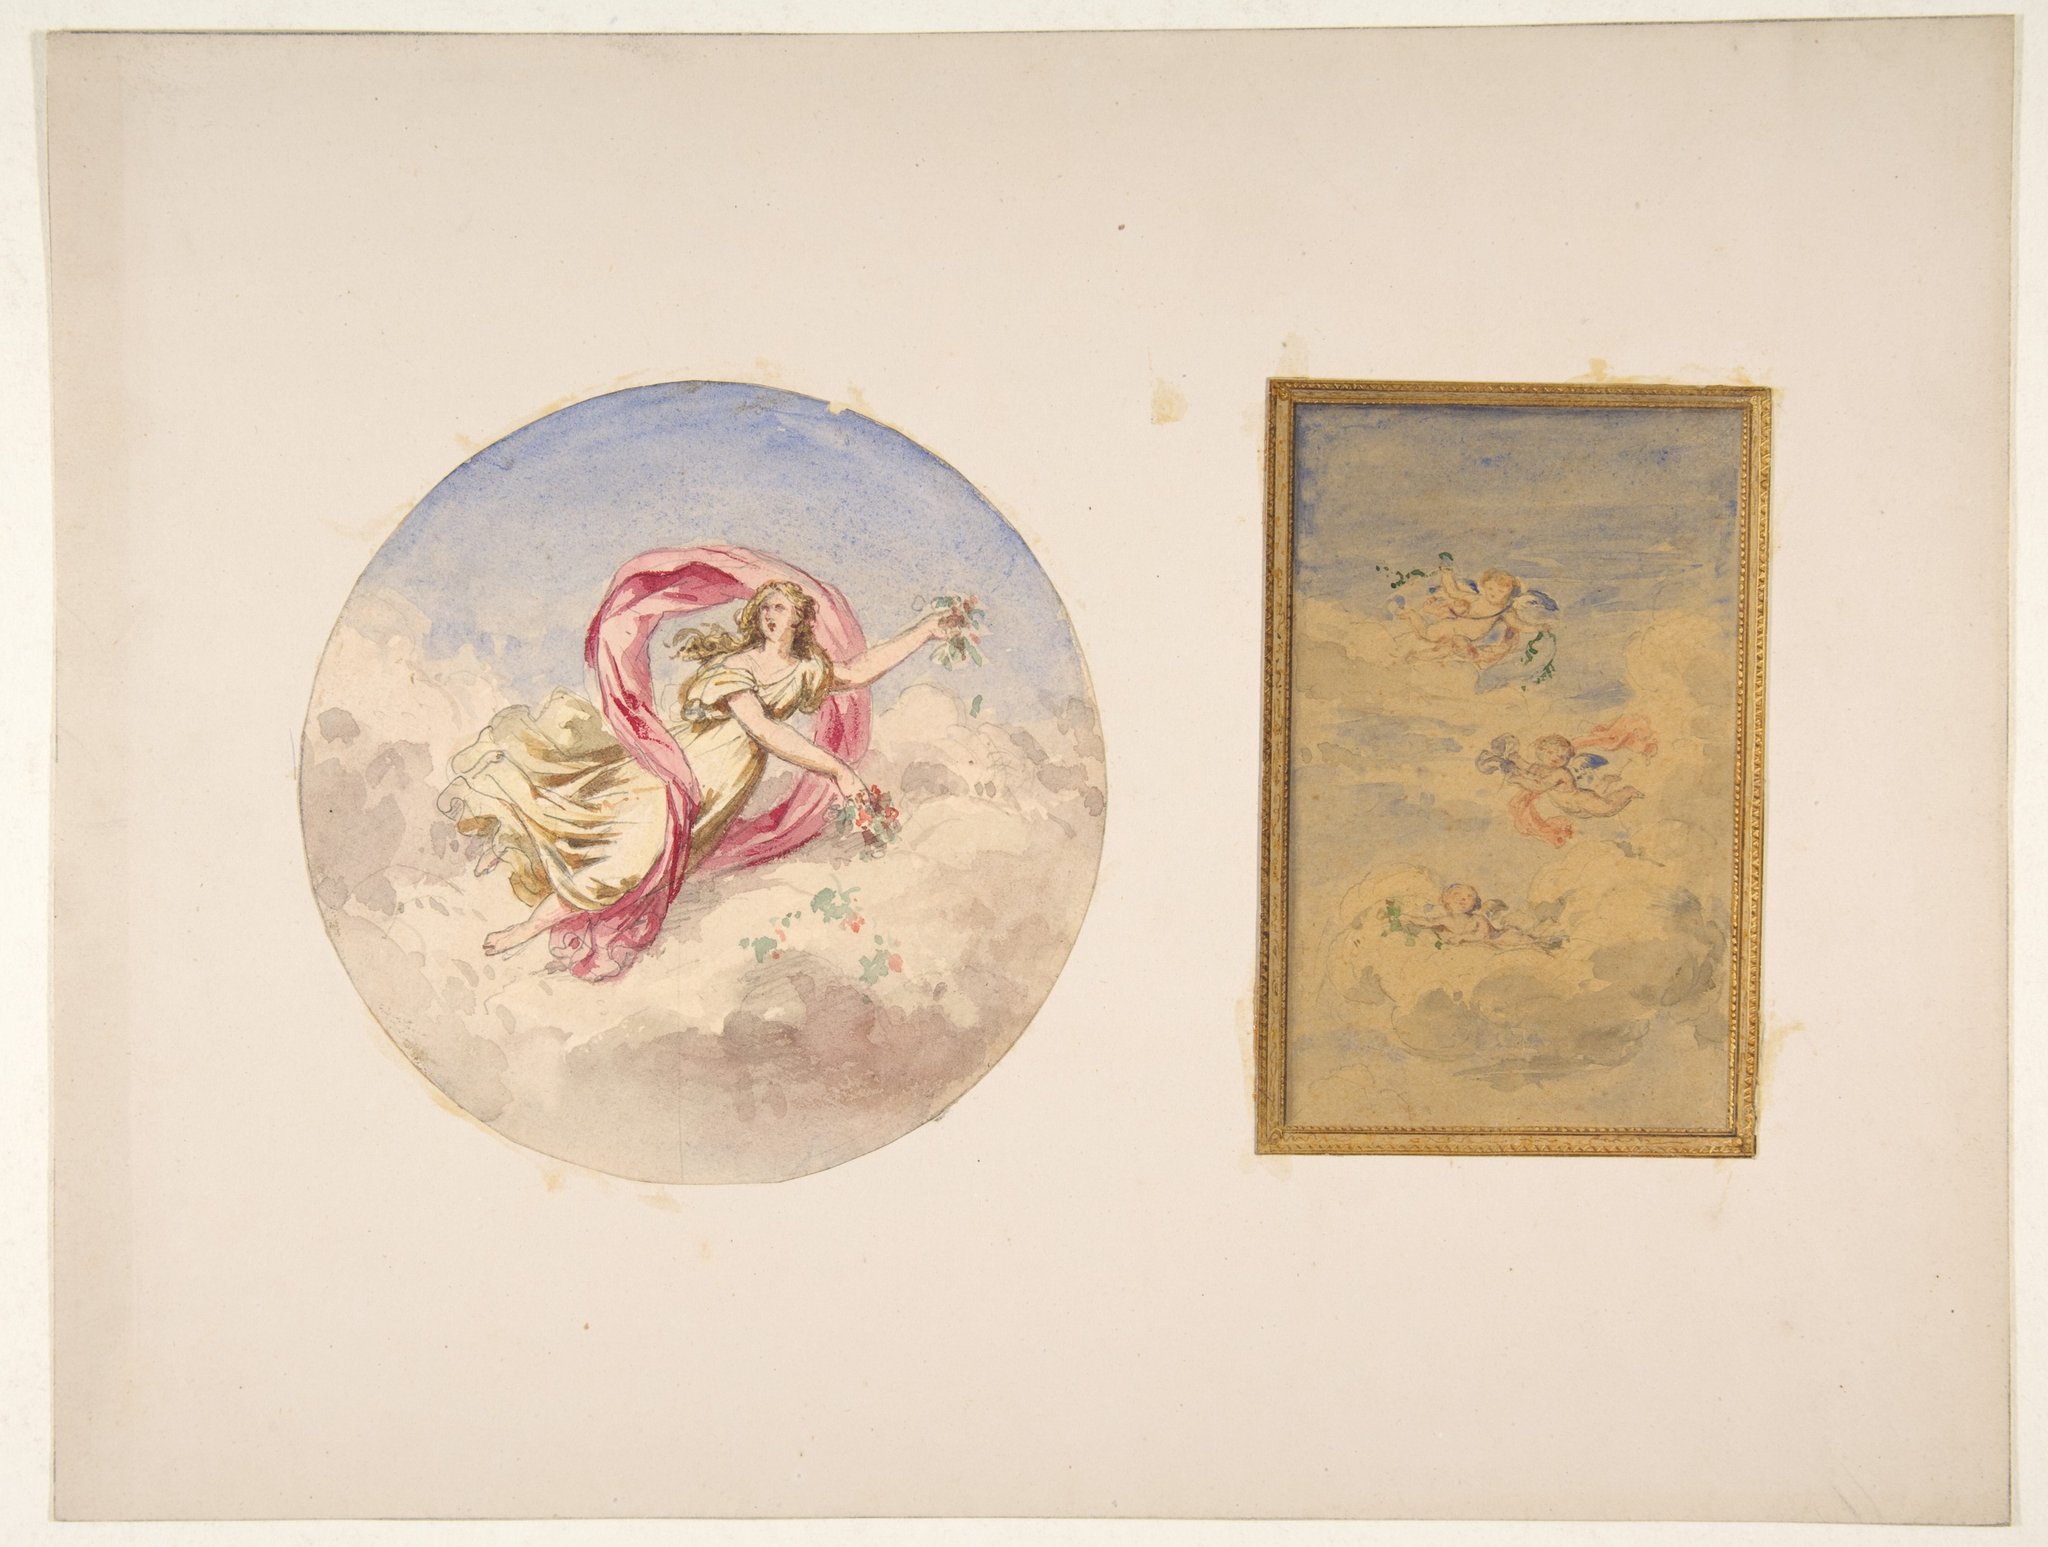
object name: drawing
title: Two designs for the decoration of ceilings with figures in clouds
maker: jules-edmond-charles lachaise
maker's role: artist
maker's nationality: french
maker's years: 1897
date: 1830-1897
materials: cardboard, gold paint, graphite, paper, watercolor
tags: women,putti